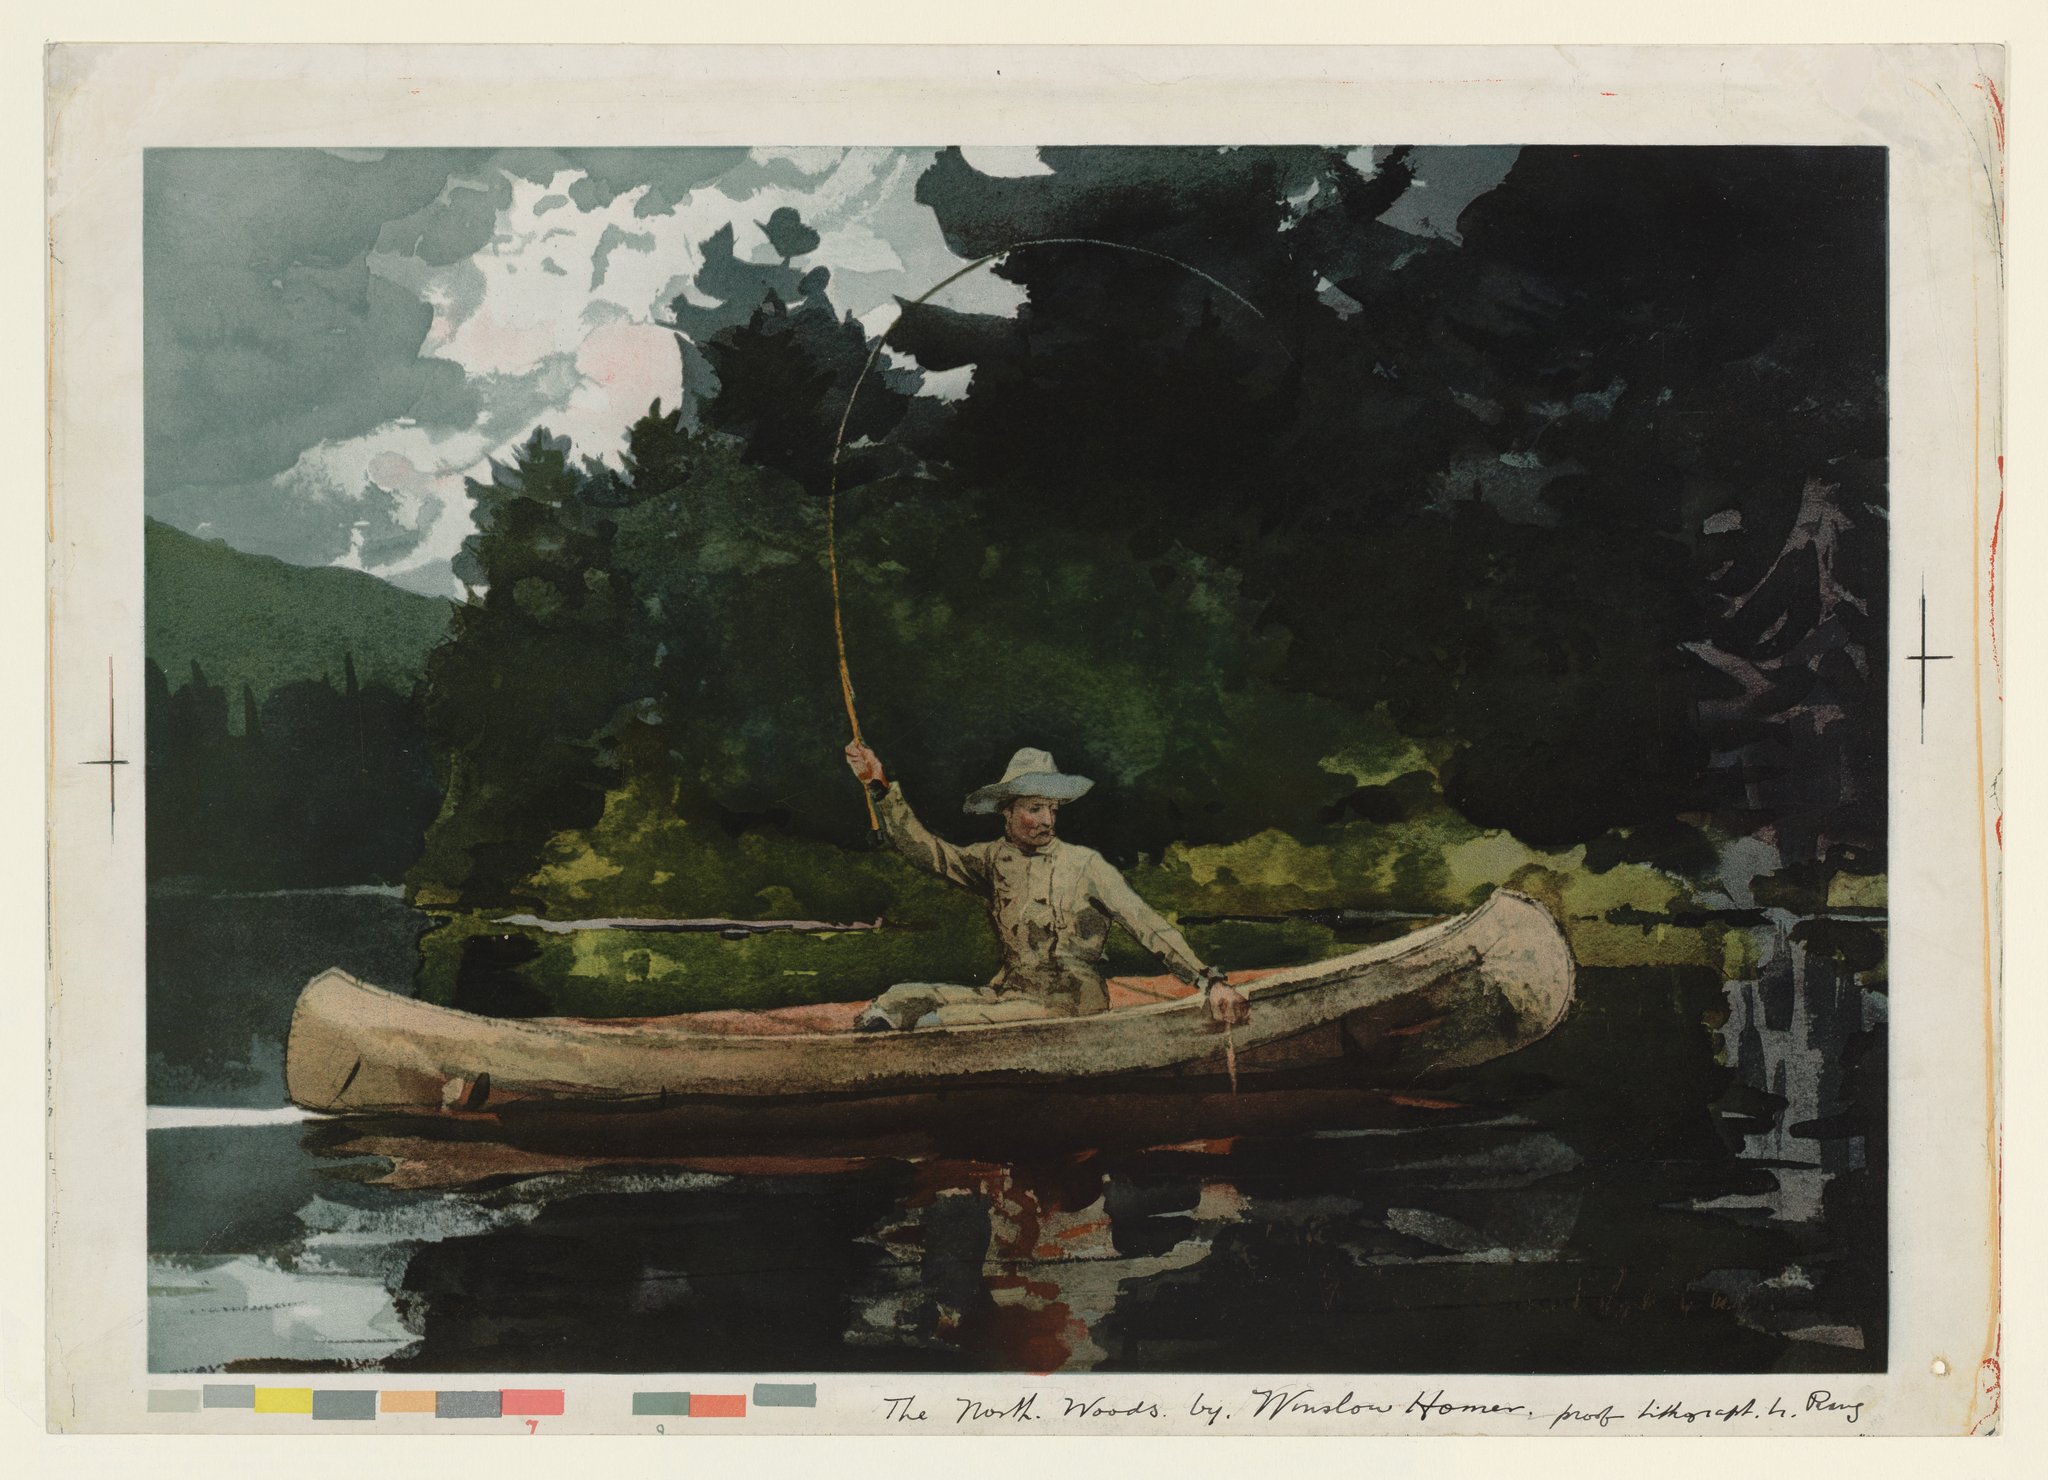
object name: print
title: The North Woods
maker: winslow homer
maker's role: artist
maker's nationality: american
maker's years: 1836-1910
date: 1896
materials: watercolor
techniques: lithograph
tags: boats